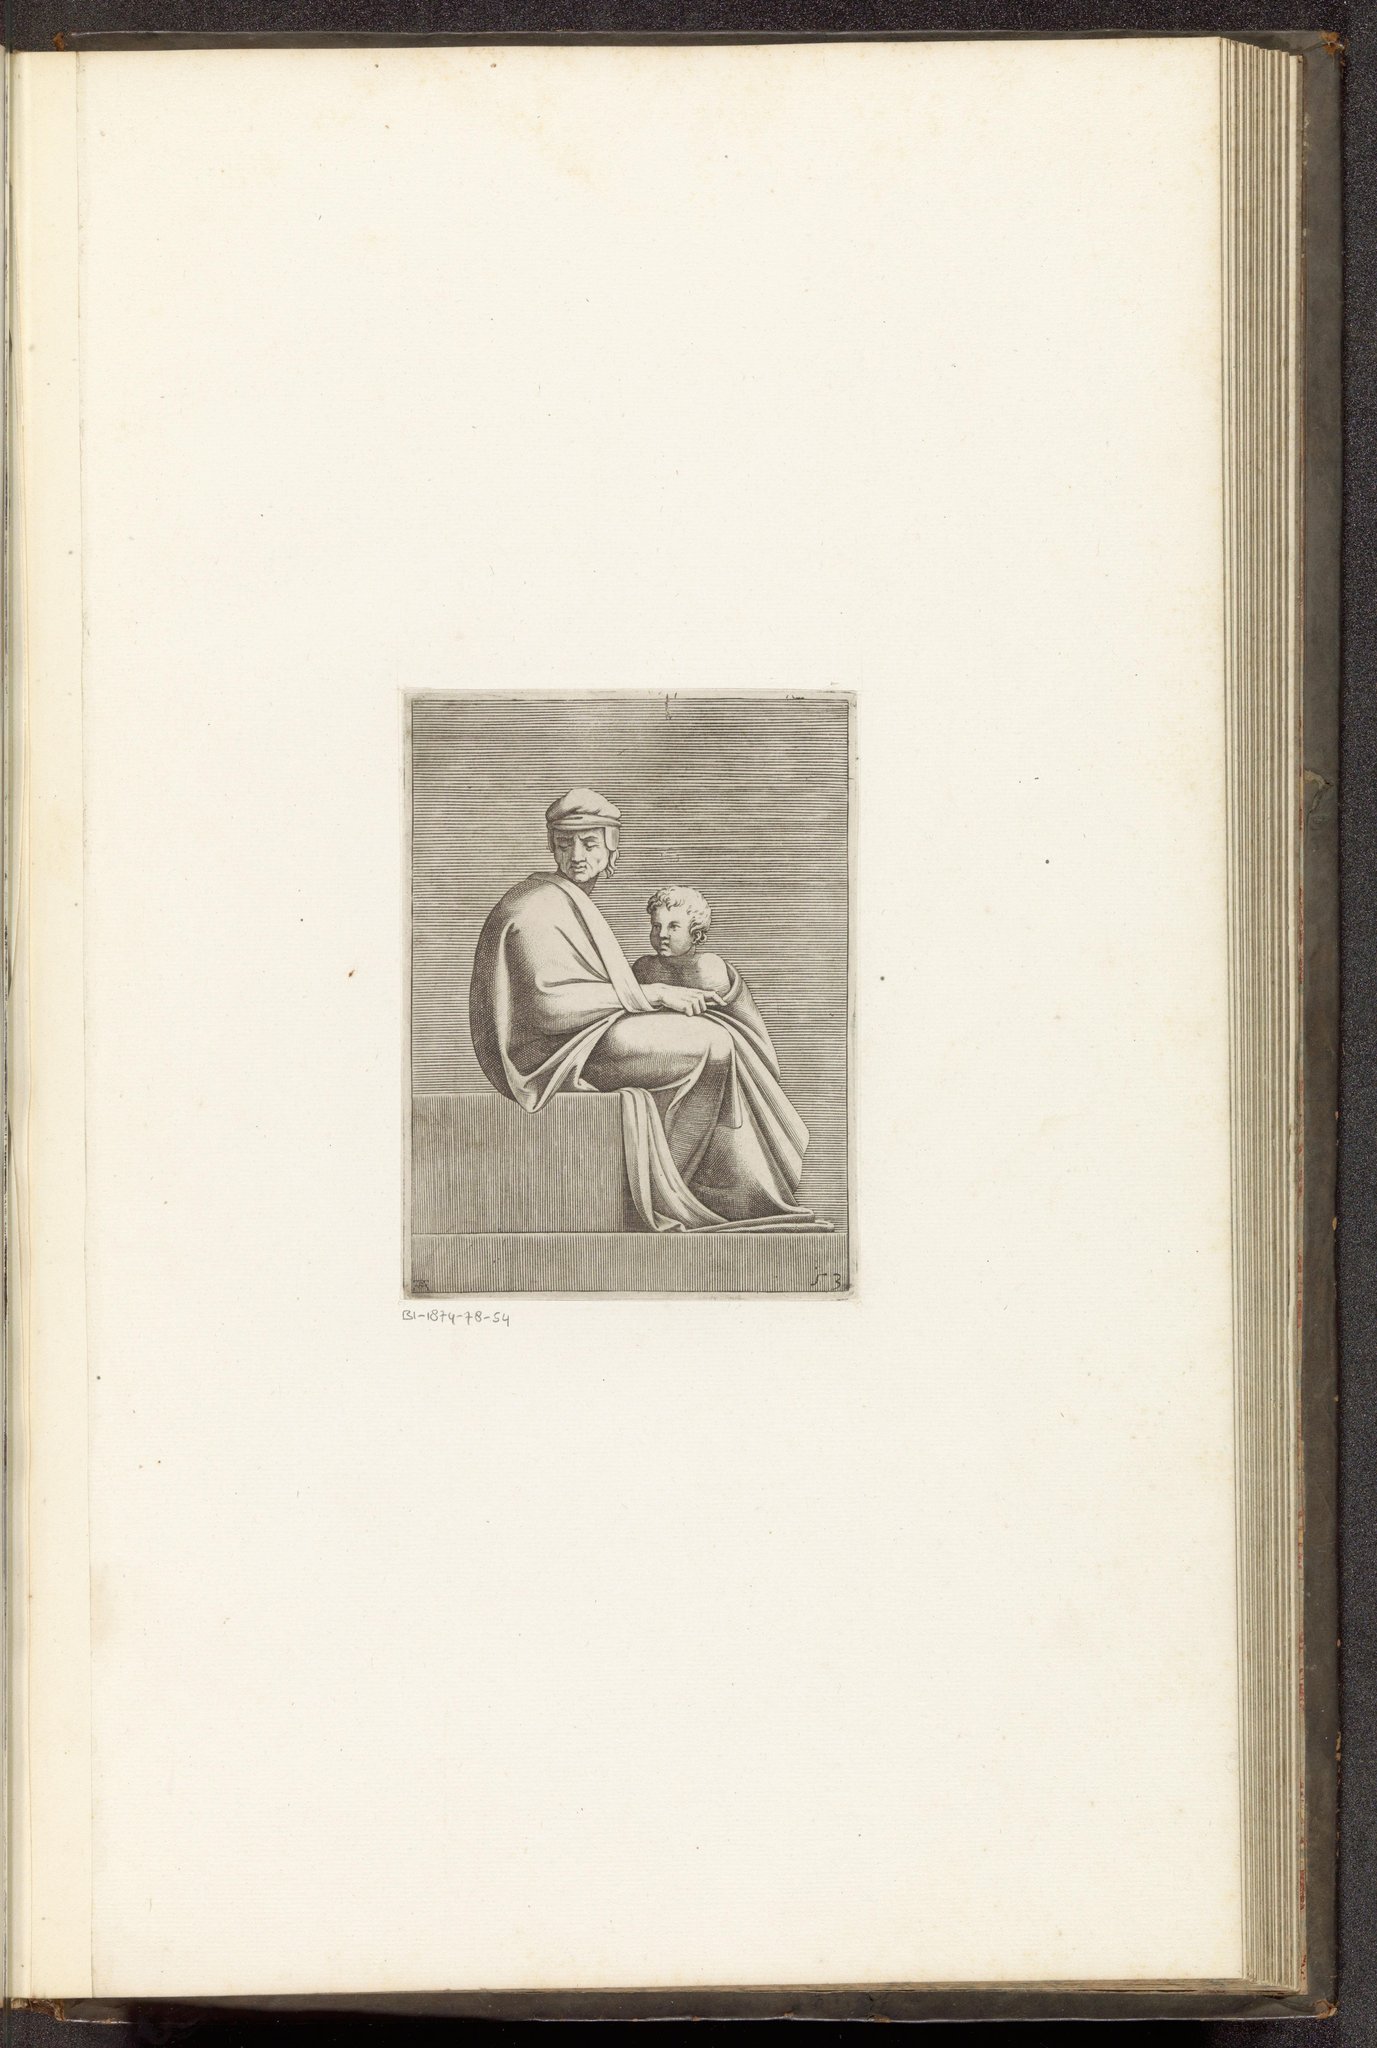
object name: album leaf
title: Zittende man met kind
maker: adamo scultori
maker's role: painter, print maker, sculptor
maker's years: 1530-1585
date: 1585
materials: paper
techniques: engraving, intaglio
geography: italy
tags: father and child(ren), man and child(ren) (family group)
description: Deze prent maakt deel uit van een serie bestaande uit een titelprent en 72 prenten naar schilderingen door Michelangelo in de Sixtijnse Kapel in het Vaticaan.